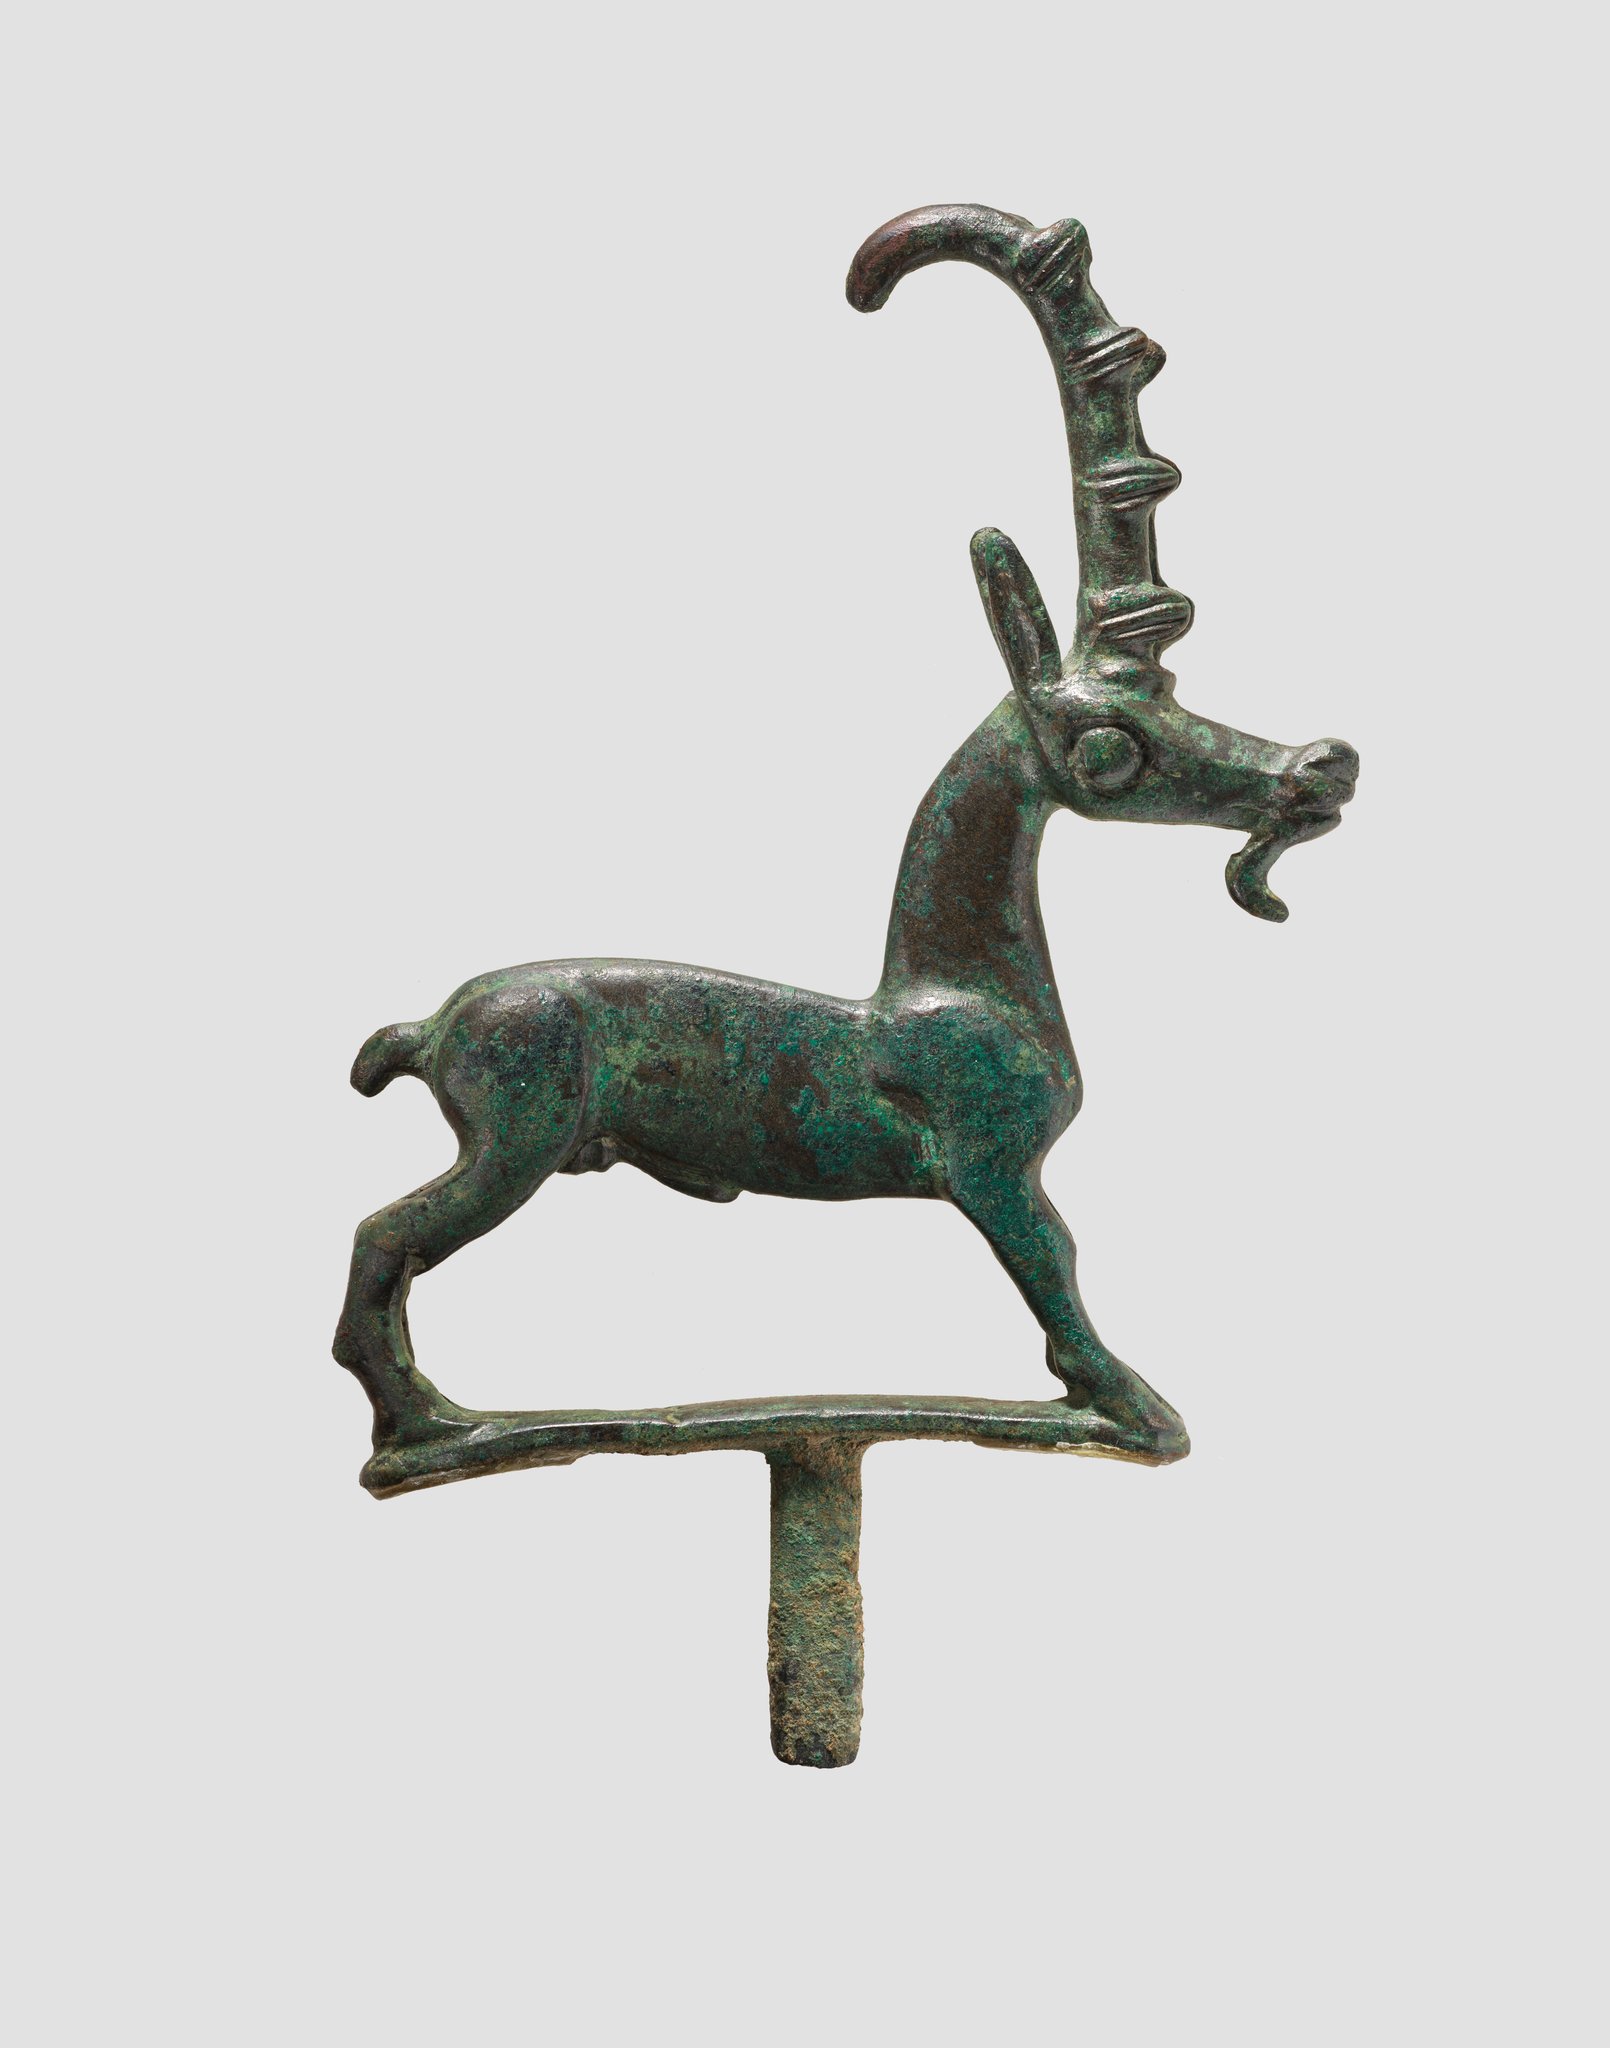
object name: pin head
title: Head of pin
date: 900-701 BCE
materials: bronze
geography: western iran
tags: ibex